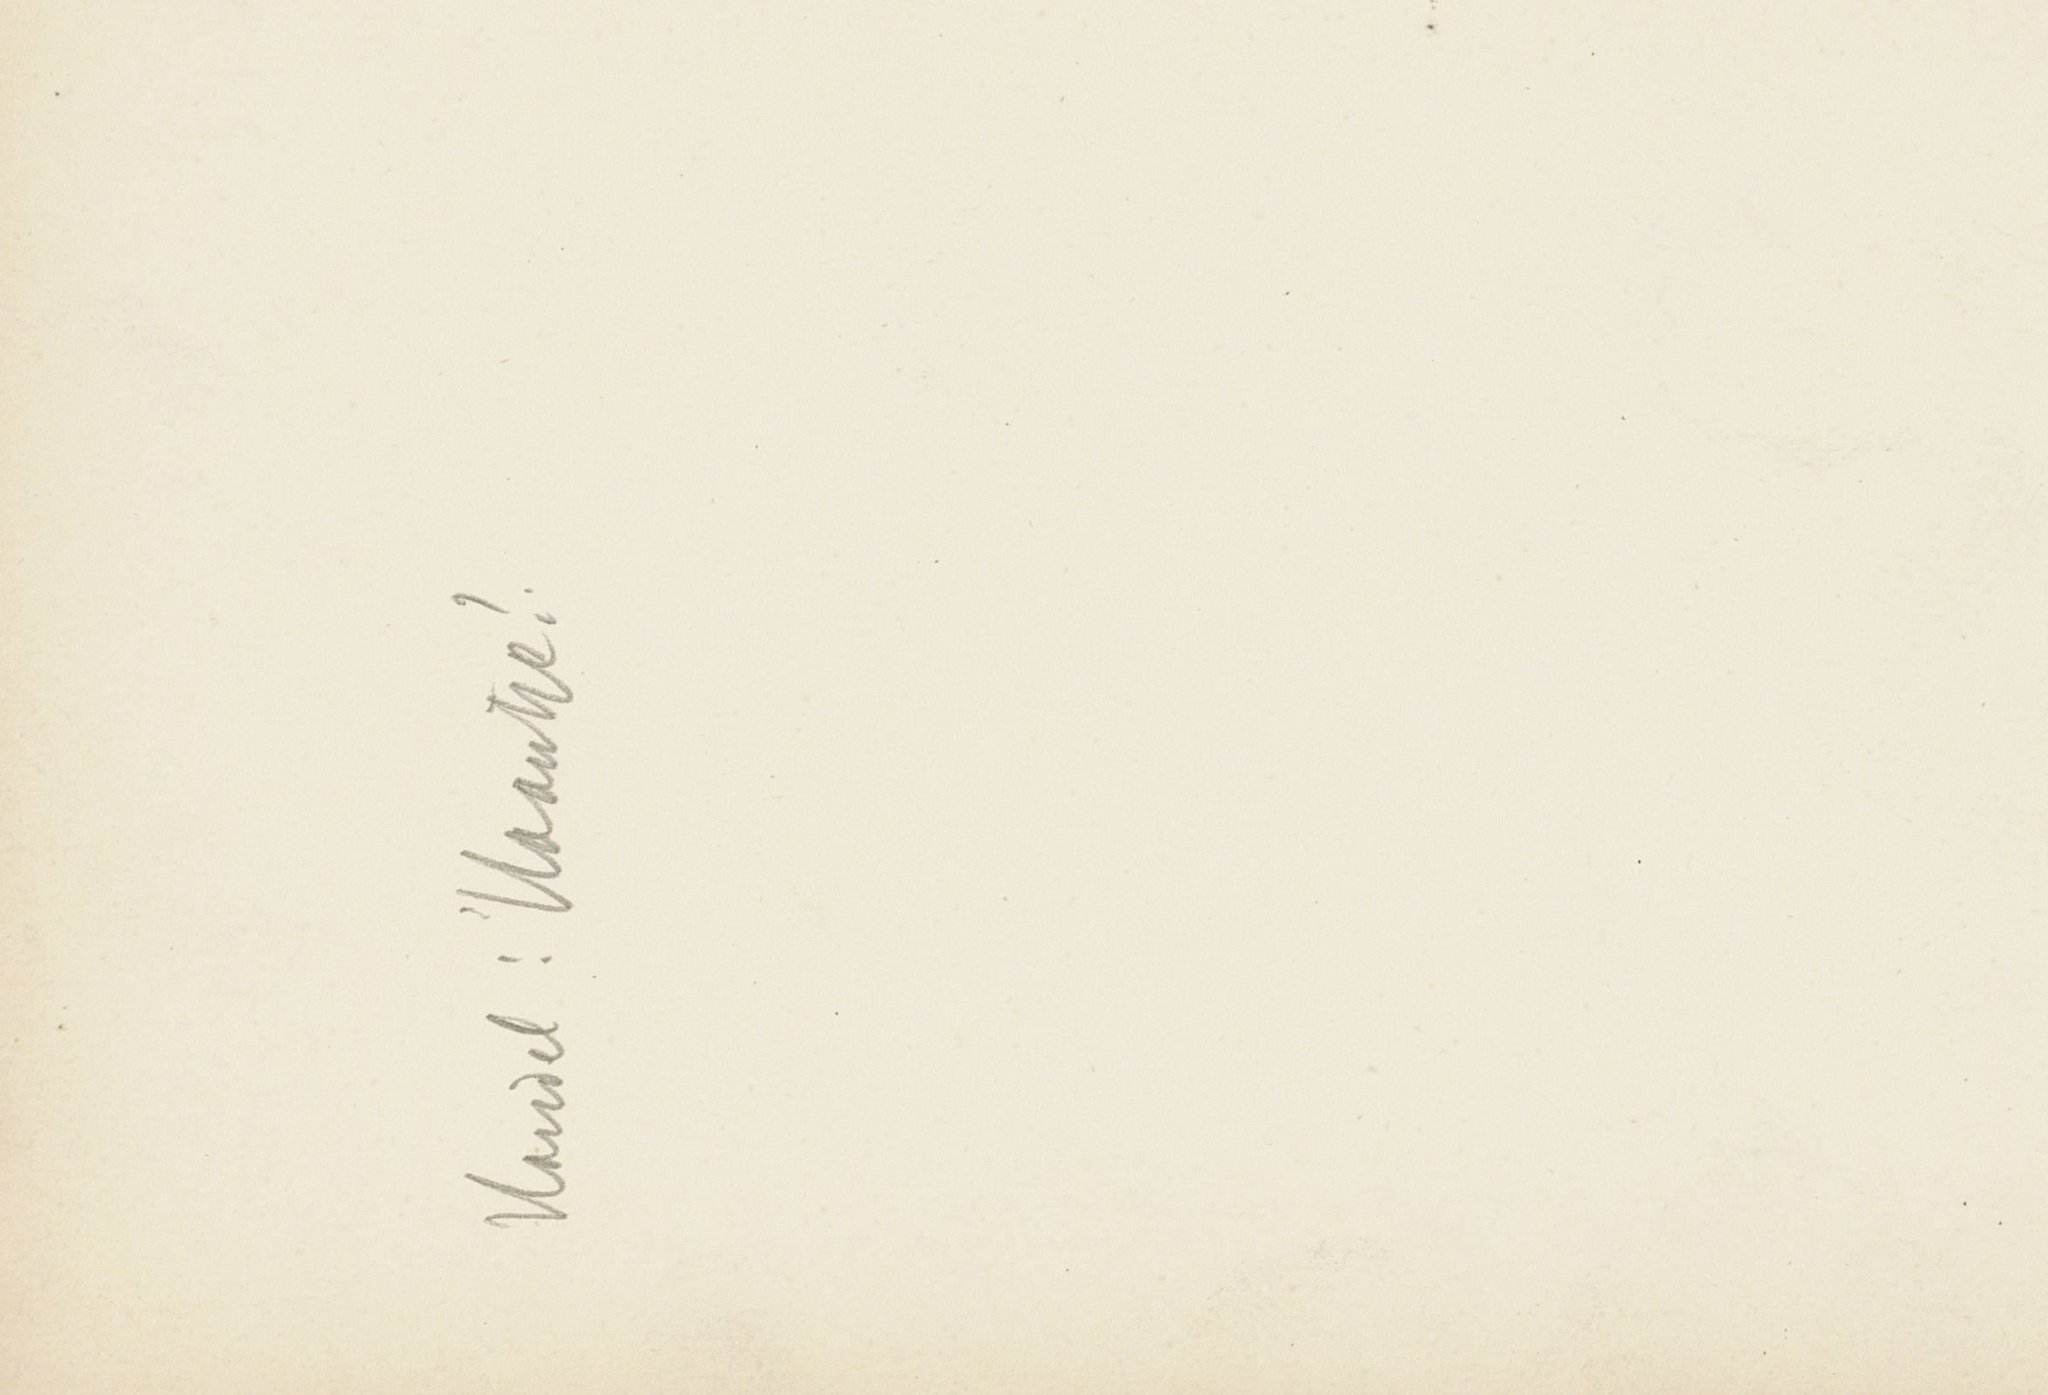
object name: sketchbook leaf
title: Notitie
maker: antoon derkinderen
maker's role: draughtsman, painter, print maker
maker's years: 1859-1925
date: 1900-1903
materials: paper, pencil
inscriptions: annotation: ‘Handel: Haantje?’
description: Blad 16 verso uit een schetsboek met 45 bladen.